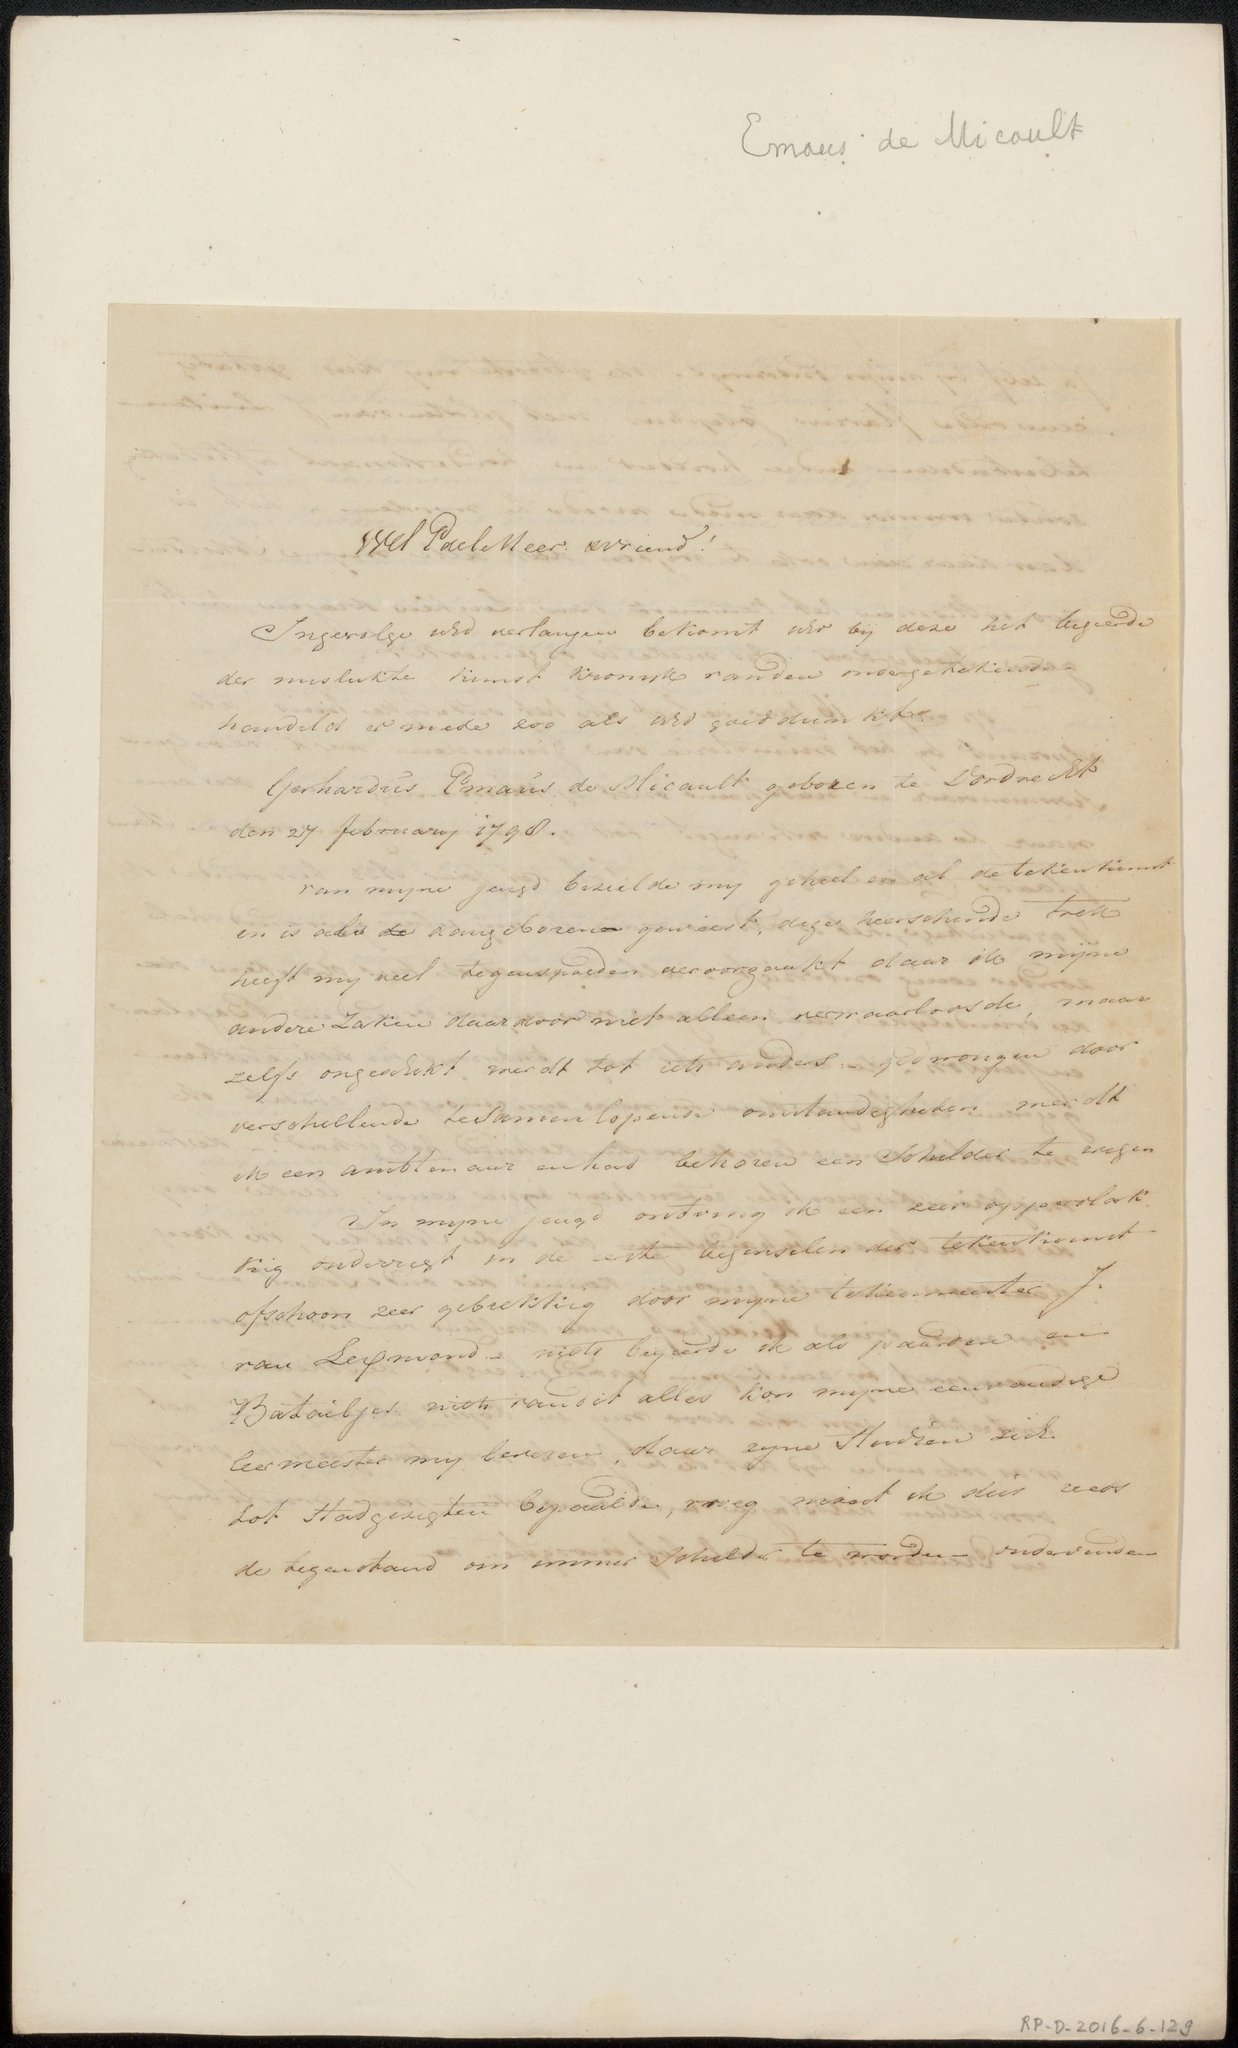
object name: letter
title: Brief aan Lambertus Johannes Hansen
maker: gerardus emaus de micault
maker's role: draughtsman, print maker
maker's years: 1798-1863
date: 1844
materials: ink, paper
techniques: pen, writing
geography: culemborg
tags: gouda, gerardus emaus de micault, amsterdam, painter, print maker, draughtsman, lambertus johannes hansen